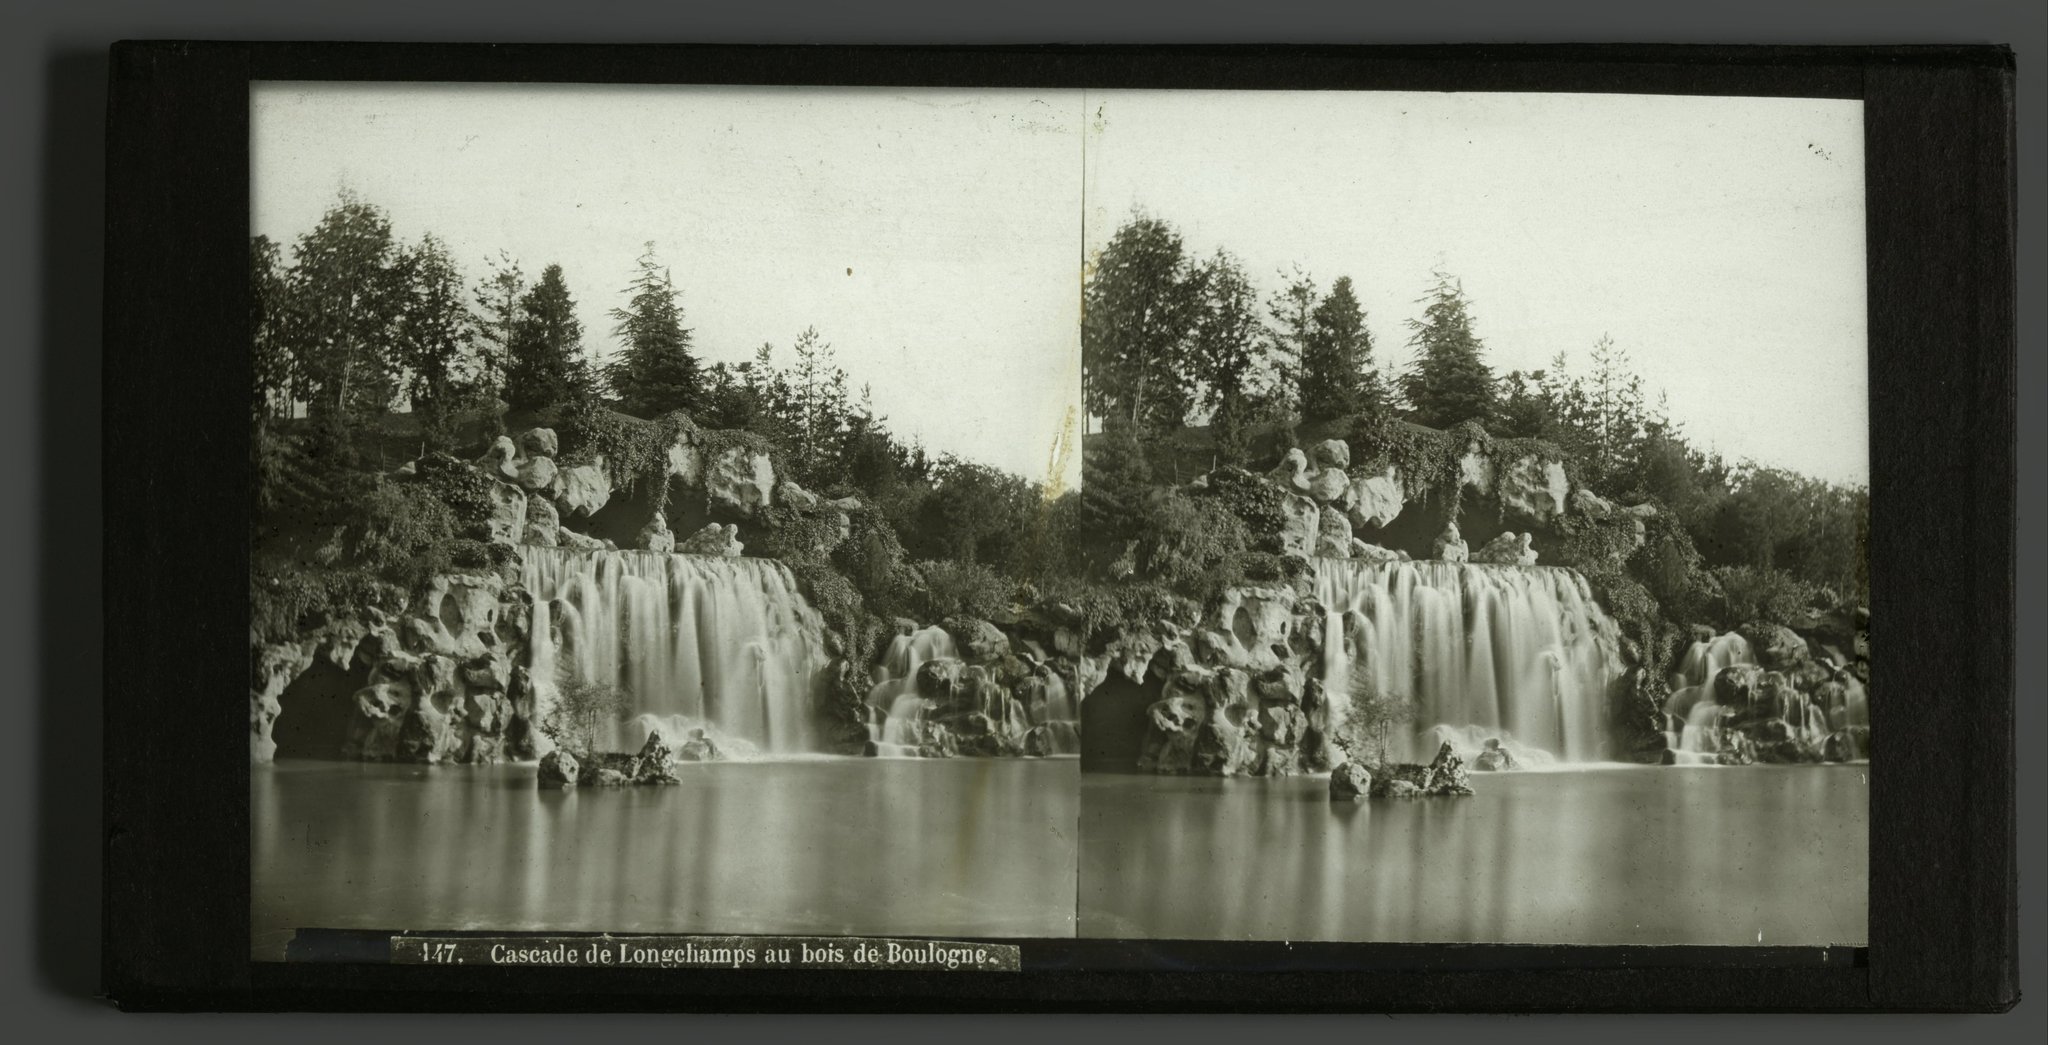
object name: photograph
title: Waterval in het Bois de Boulogne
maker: ferrier père-fils et soulier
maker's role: publisher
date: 1859-1867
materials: glass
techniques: slide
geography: bois de boulogne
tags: waterfall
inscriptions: number: ‘147.’